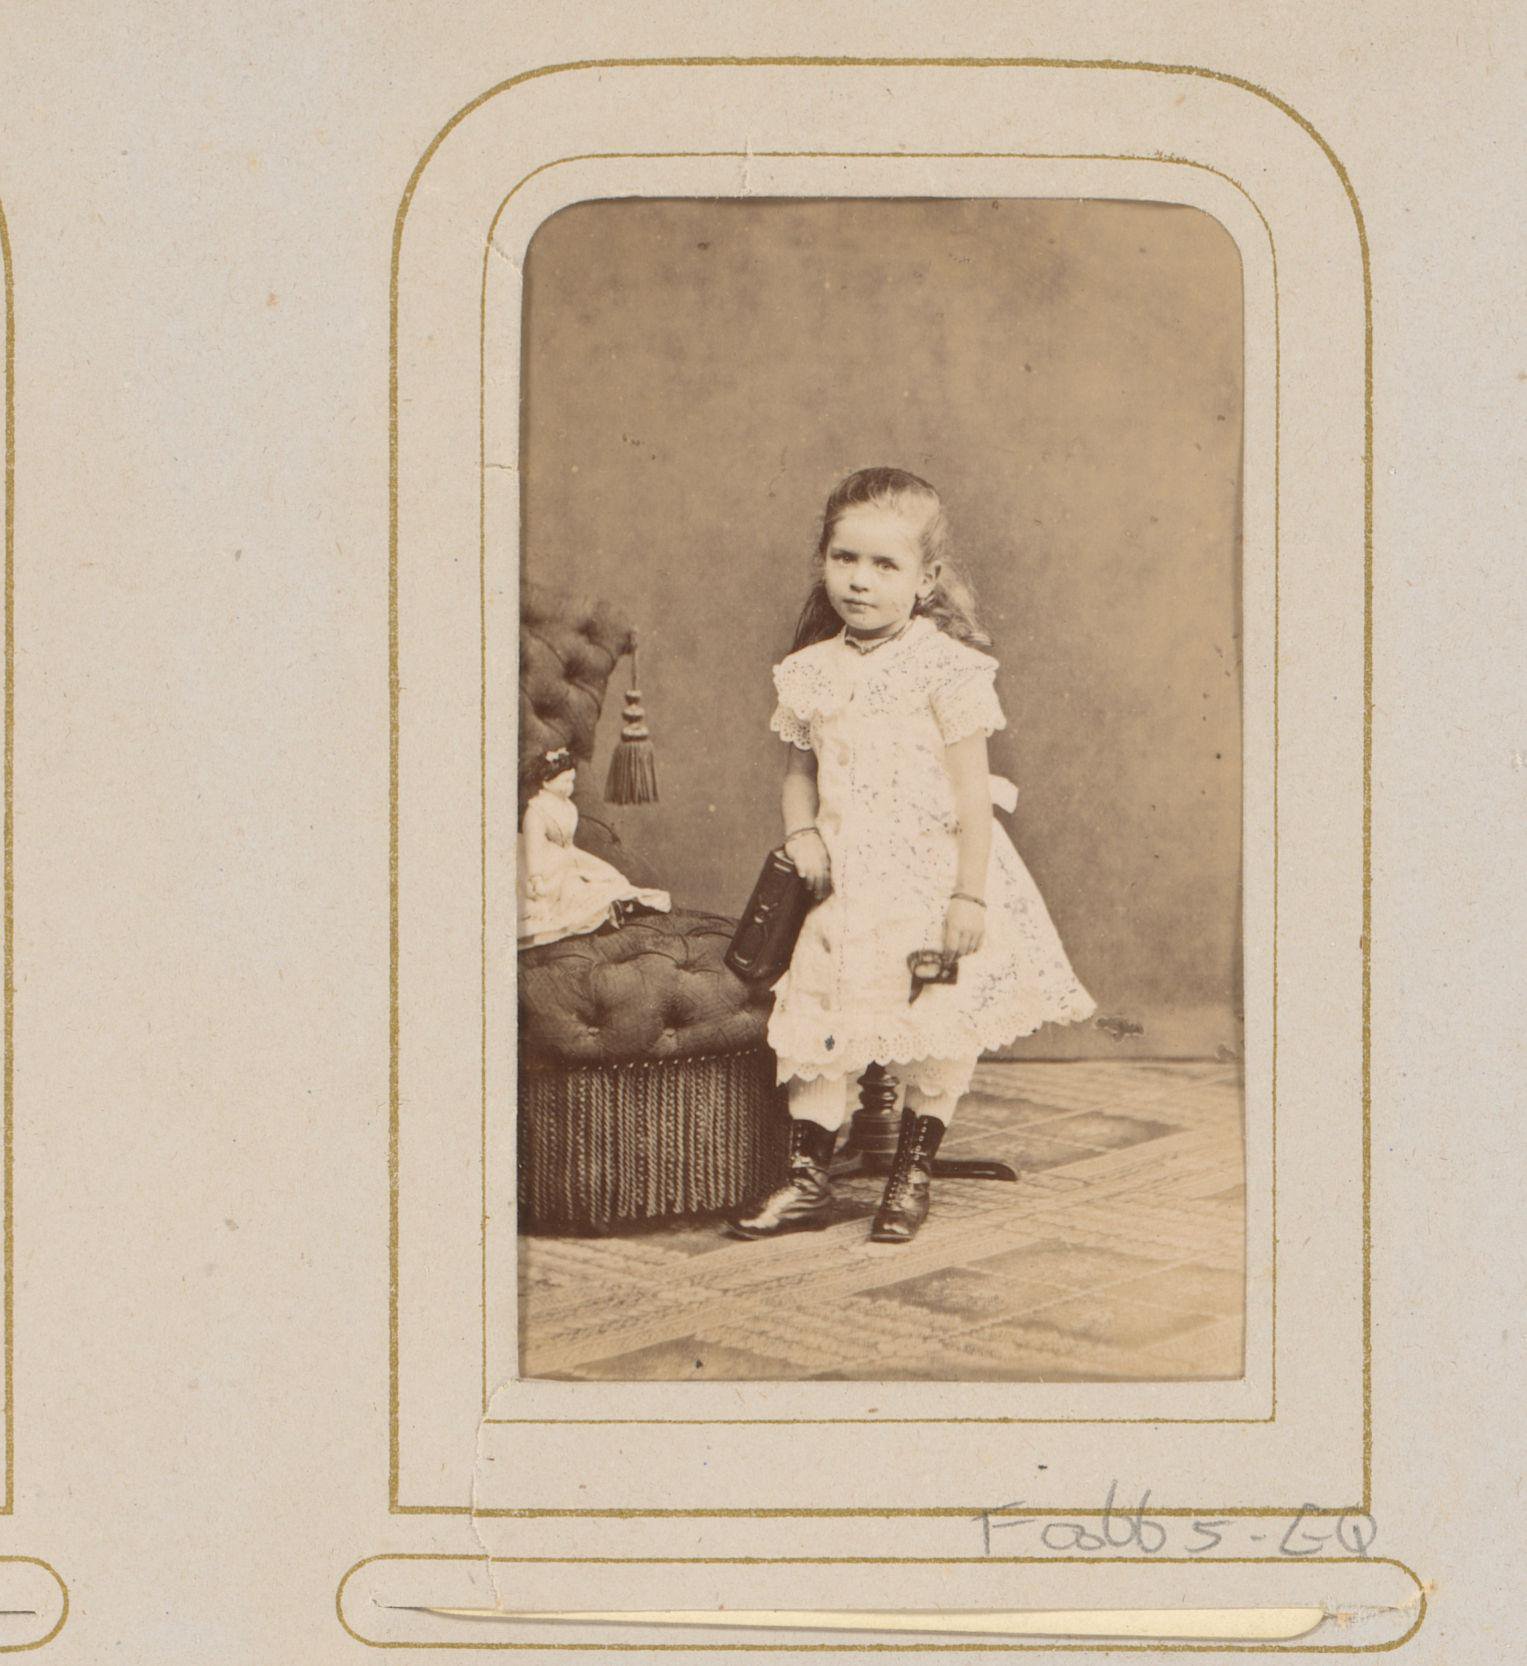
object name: album leaf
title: Portret van een meisje met pop en boek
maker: herman deutmann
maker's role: fotograaf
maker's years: 1870-1926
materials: cardboard, photographic support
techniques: albumen print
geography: zwolle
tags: girl (child between toddler and youth)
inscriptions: inscription: ‘Photogr. Atelier/ Deutmann/ Kamperstraat/ Zwolle’